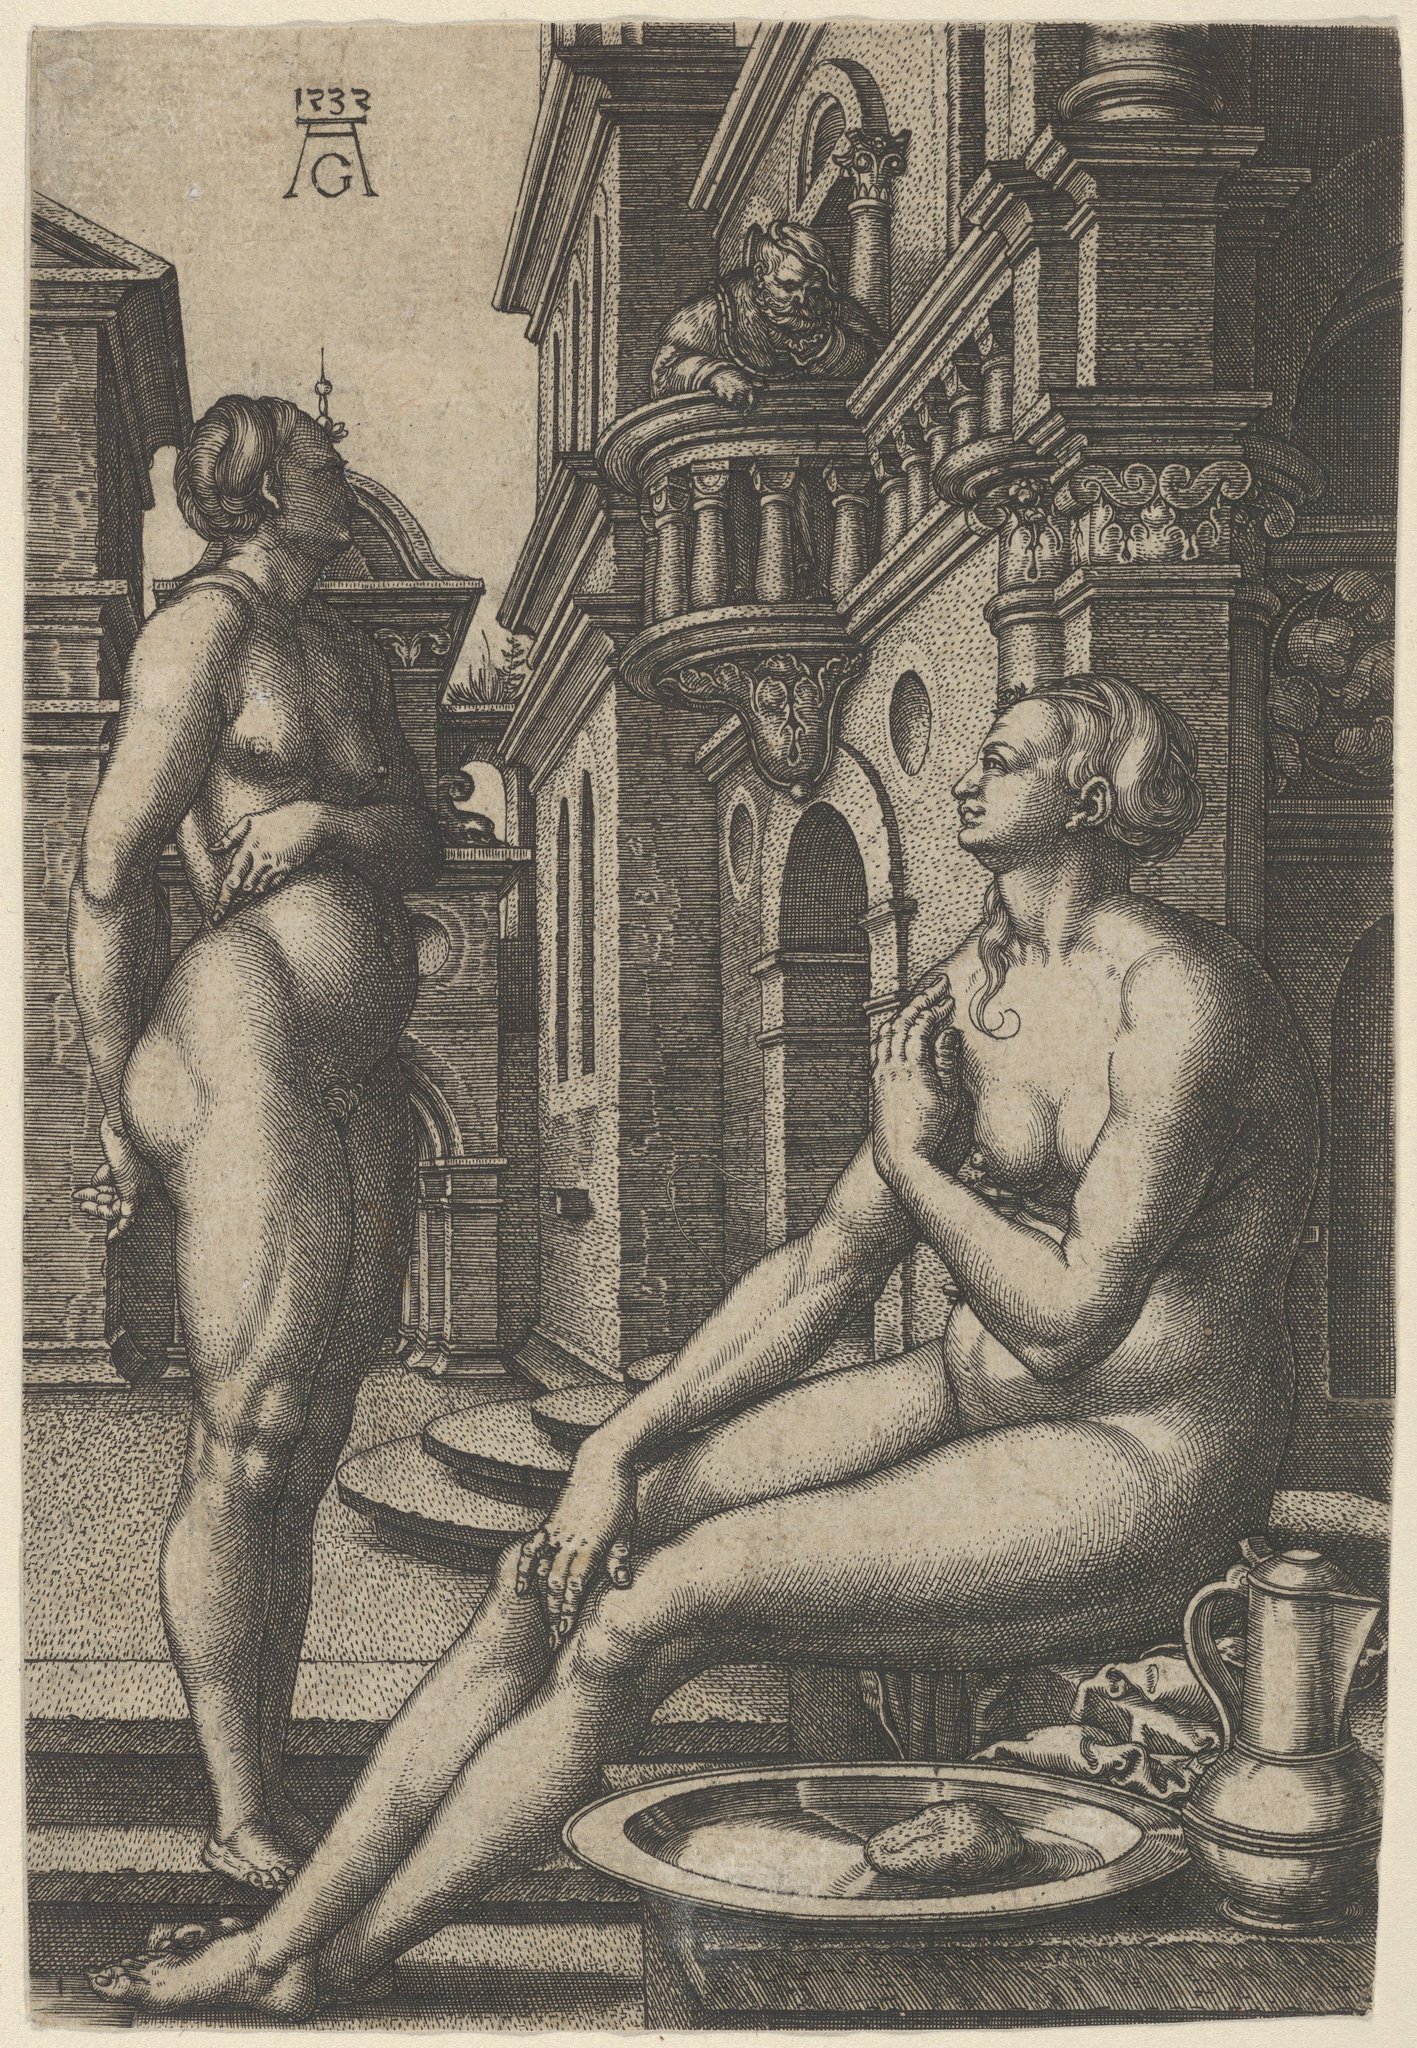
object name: print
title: Bathsheba at the Bath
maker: heinrich aldegrever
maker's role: artist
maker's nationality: german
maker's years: 1502-1561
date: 1532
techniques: engraving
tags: female nudes,bathsheba,david